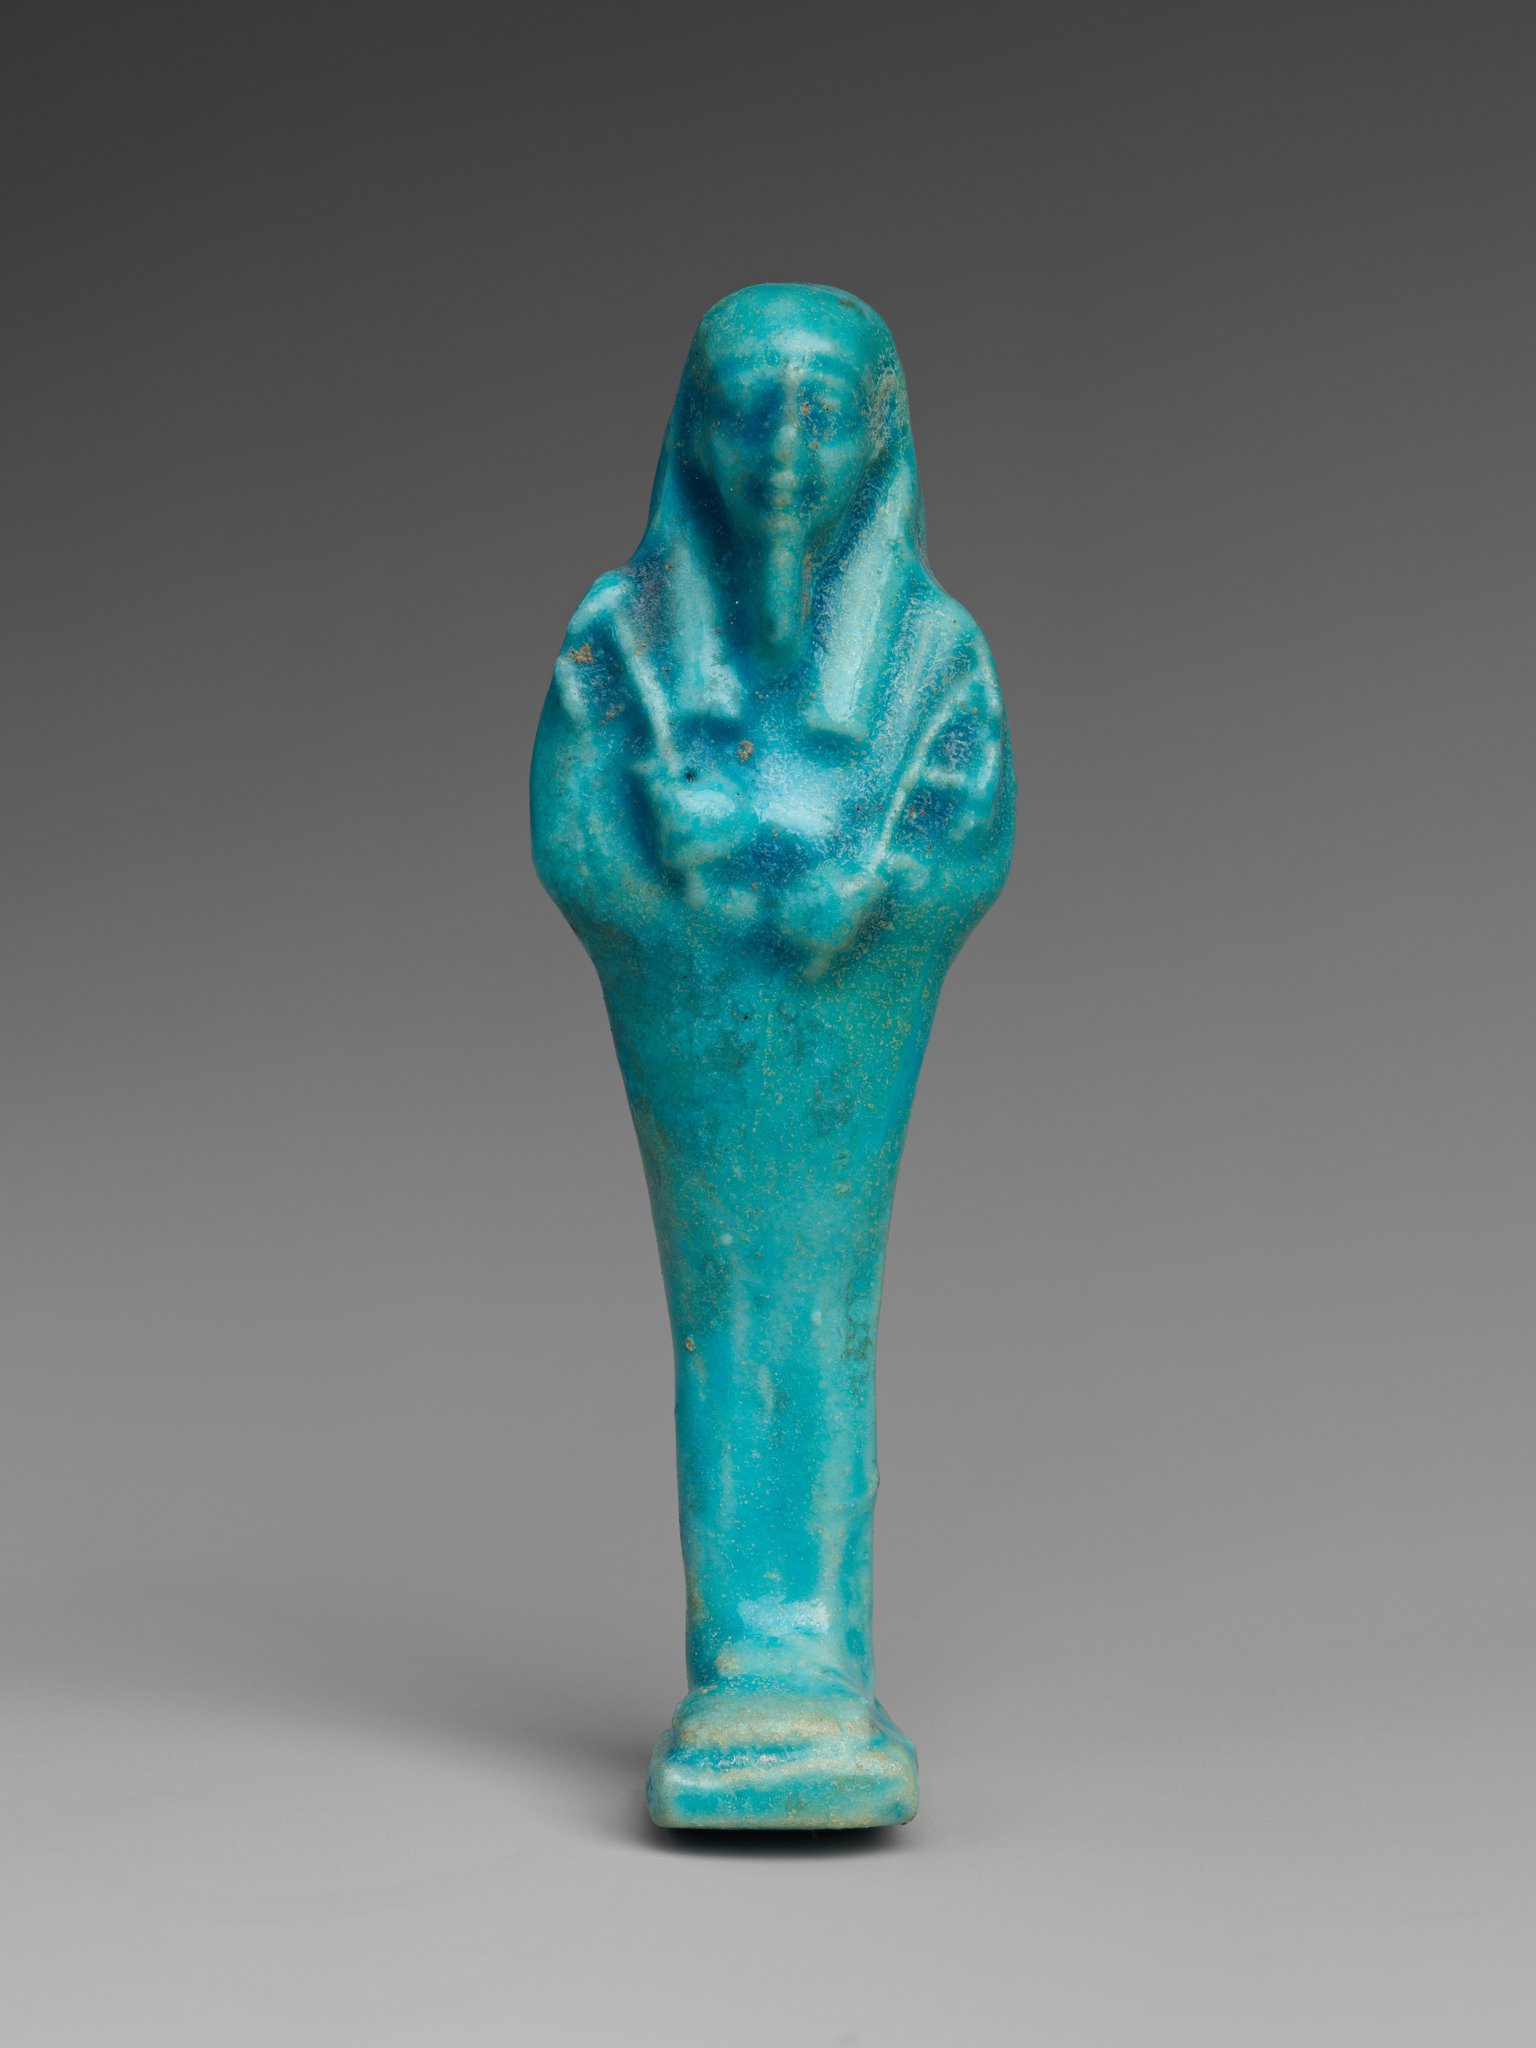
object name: shabti, petosiris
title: Shabti of Petosiris, son of Djedhor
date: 360-300 BCE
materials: faience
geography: egypt